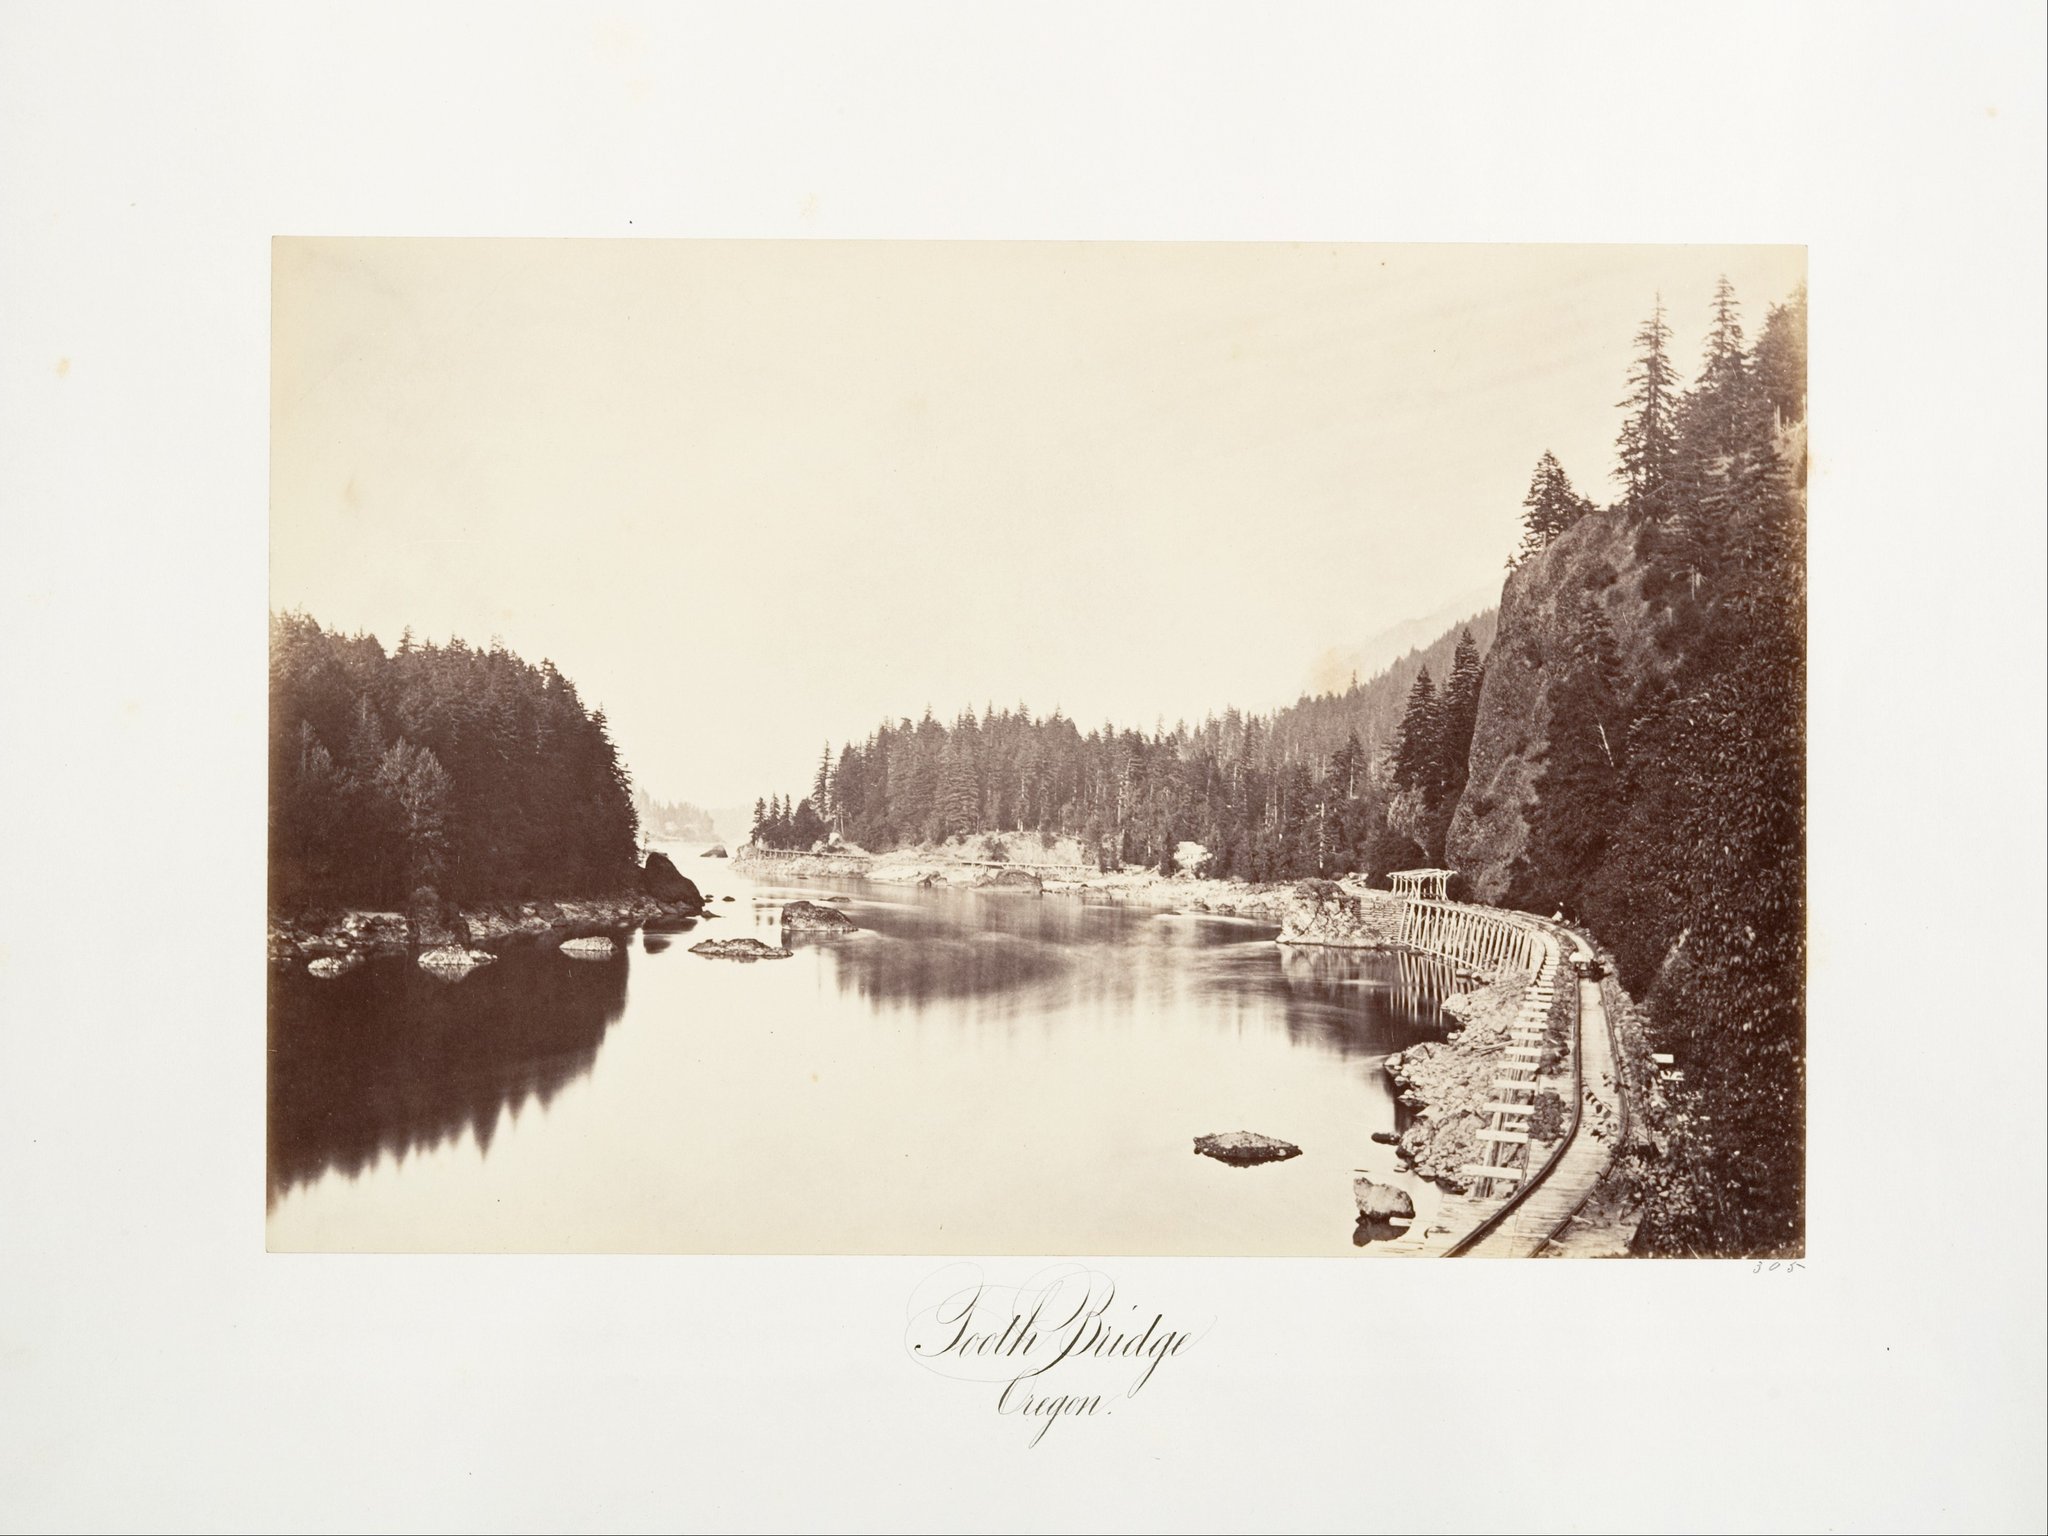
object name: photograph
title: Tooth Bridge, Oregon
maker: carleton e. watkins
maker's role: artist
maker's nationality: american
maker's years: 1829-1916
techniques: albumen silver print, glass negative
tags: railways,rivers,landscapes